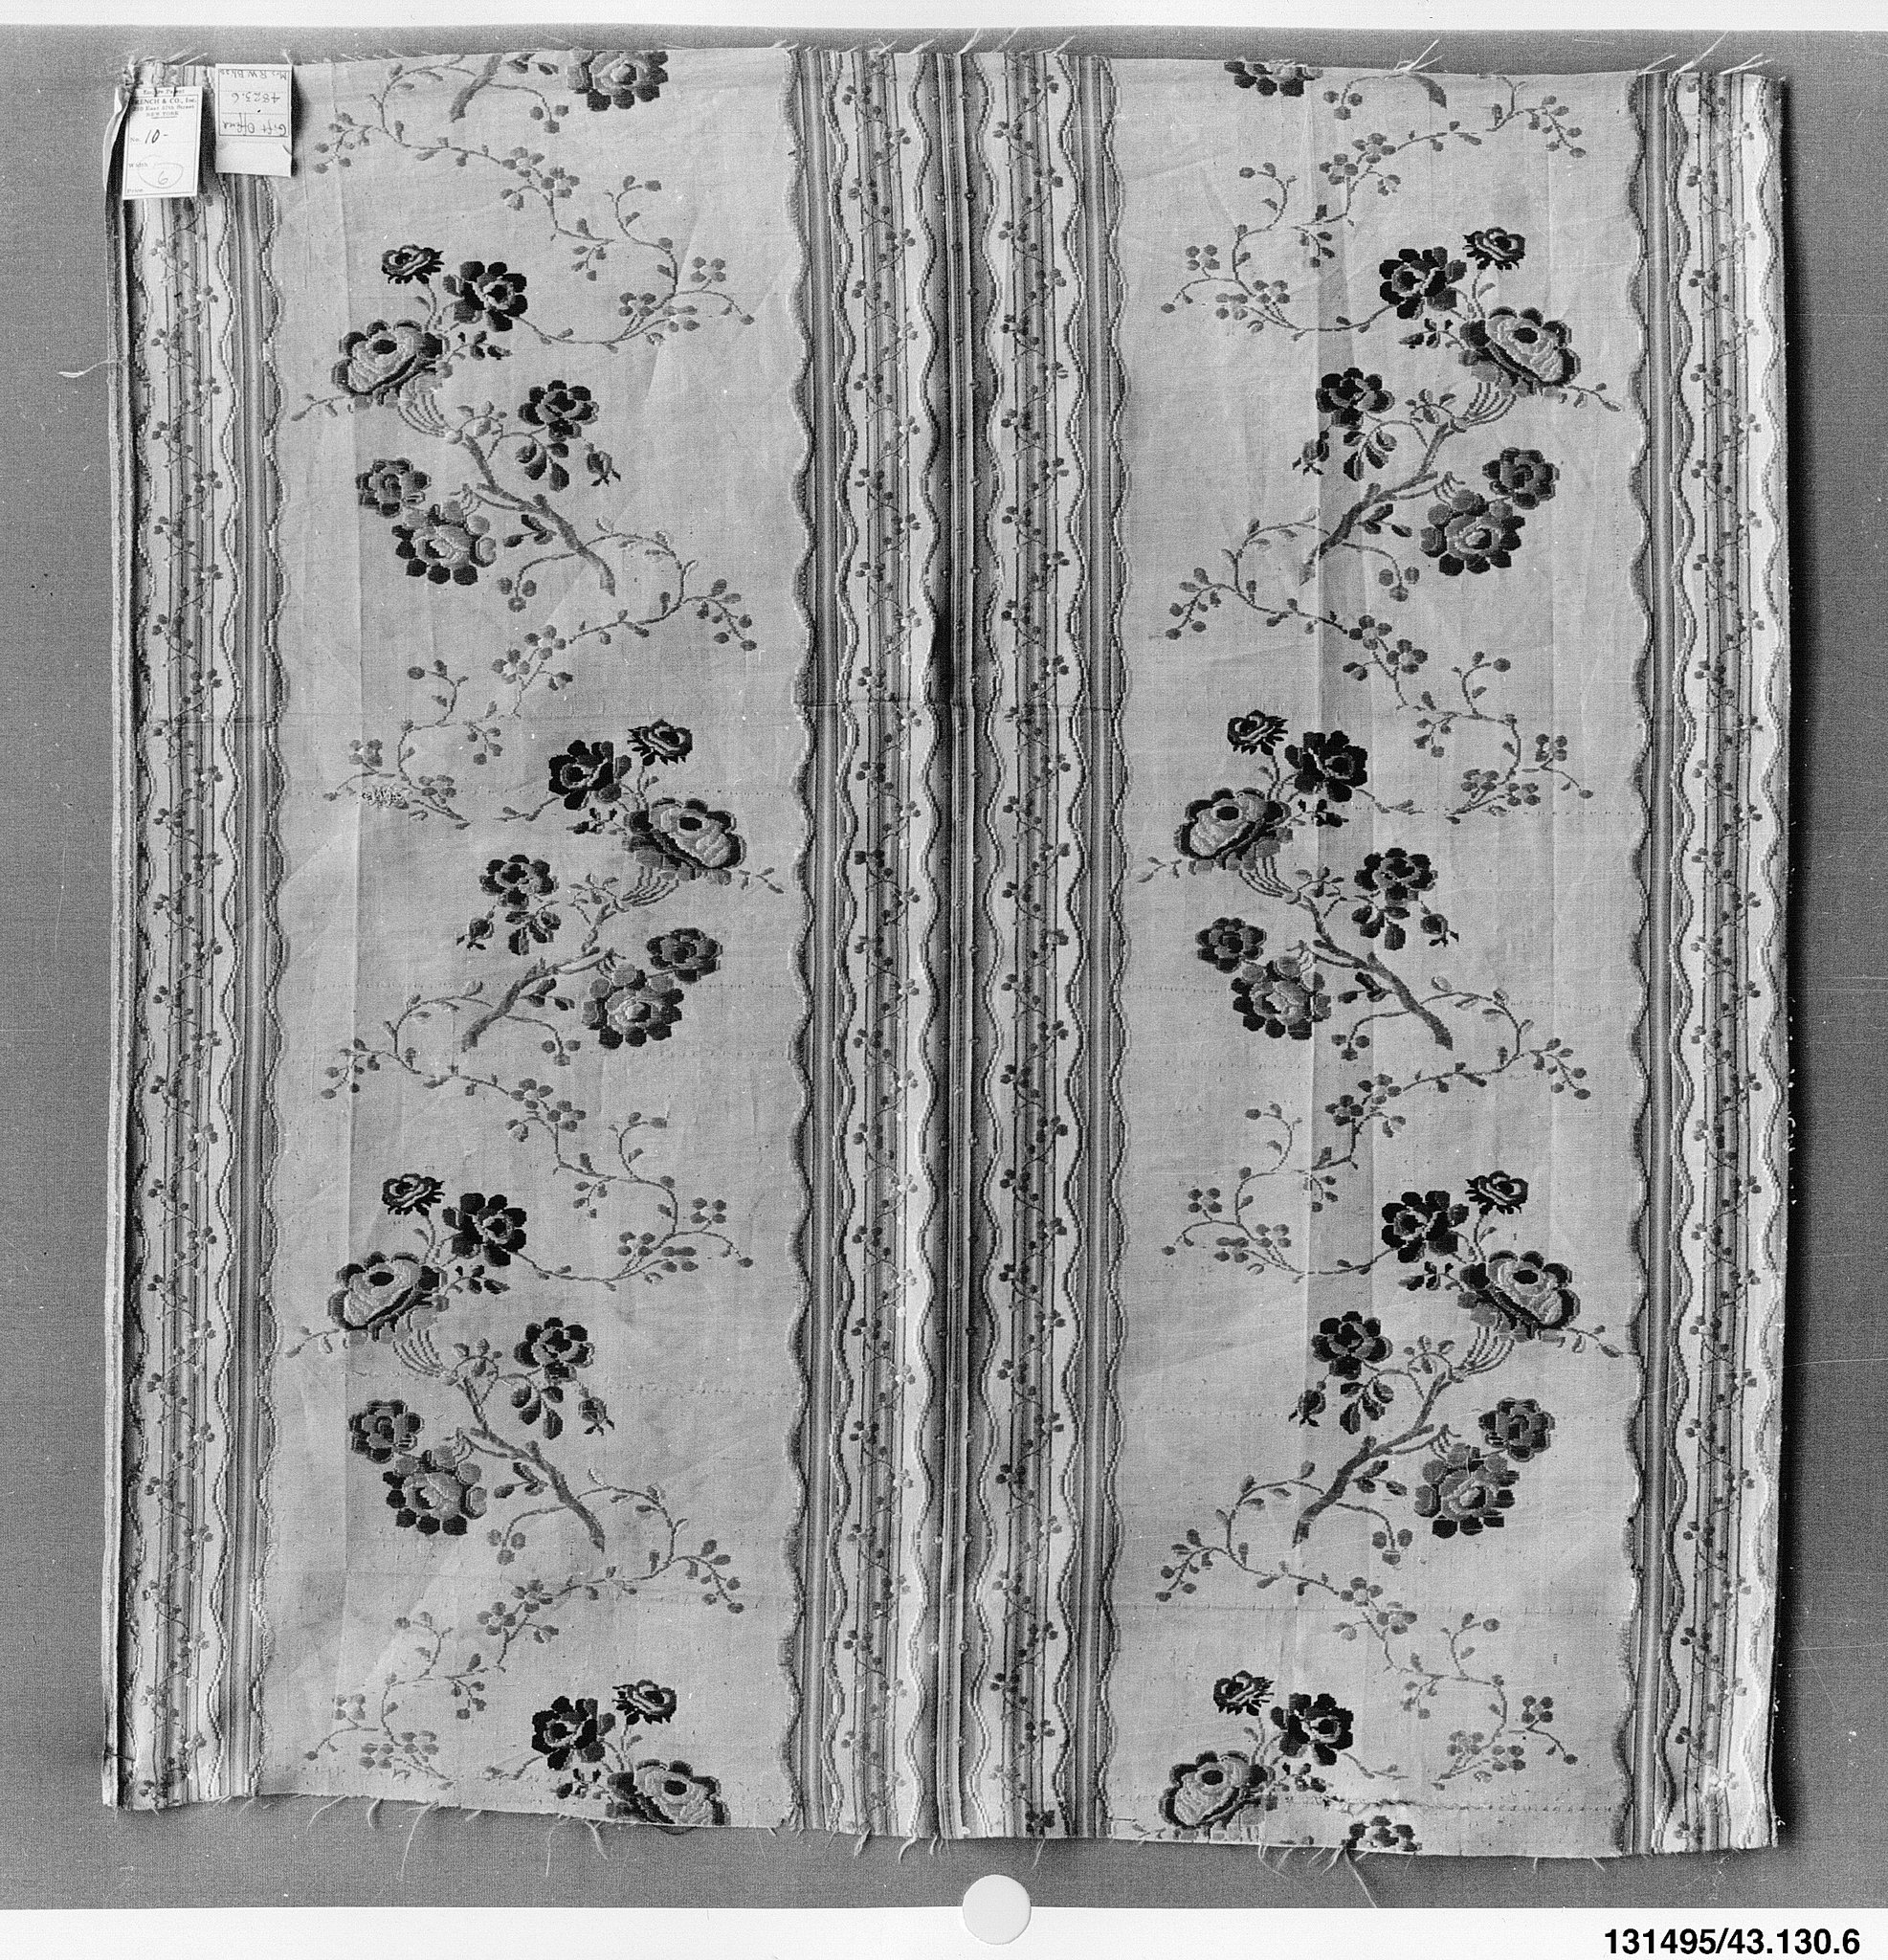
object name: piece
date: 1767-1800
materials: silk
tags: flowers,leaves